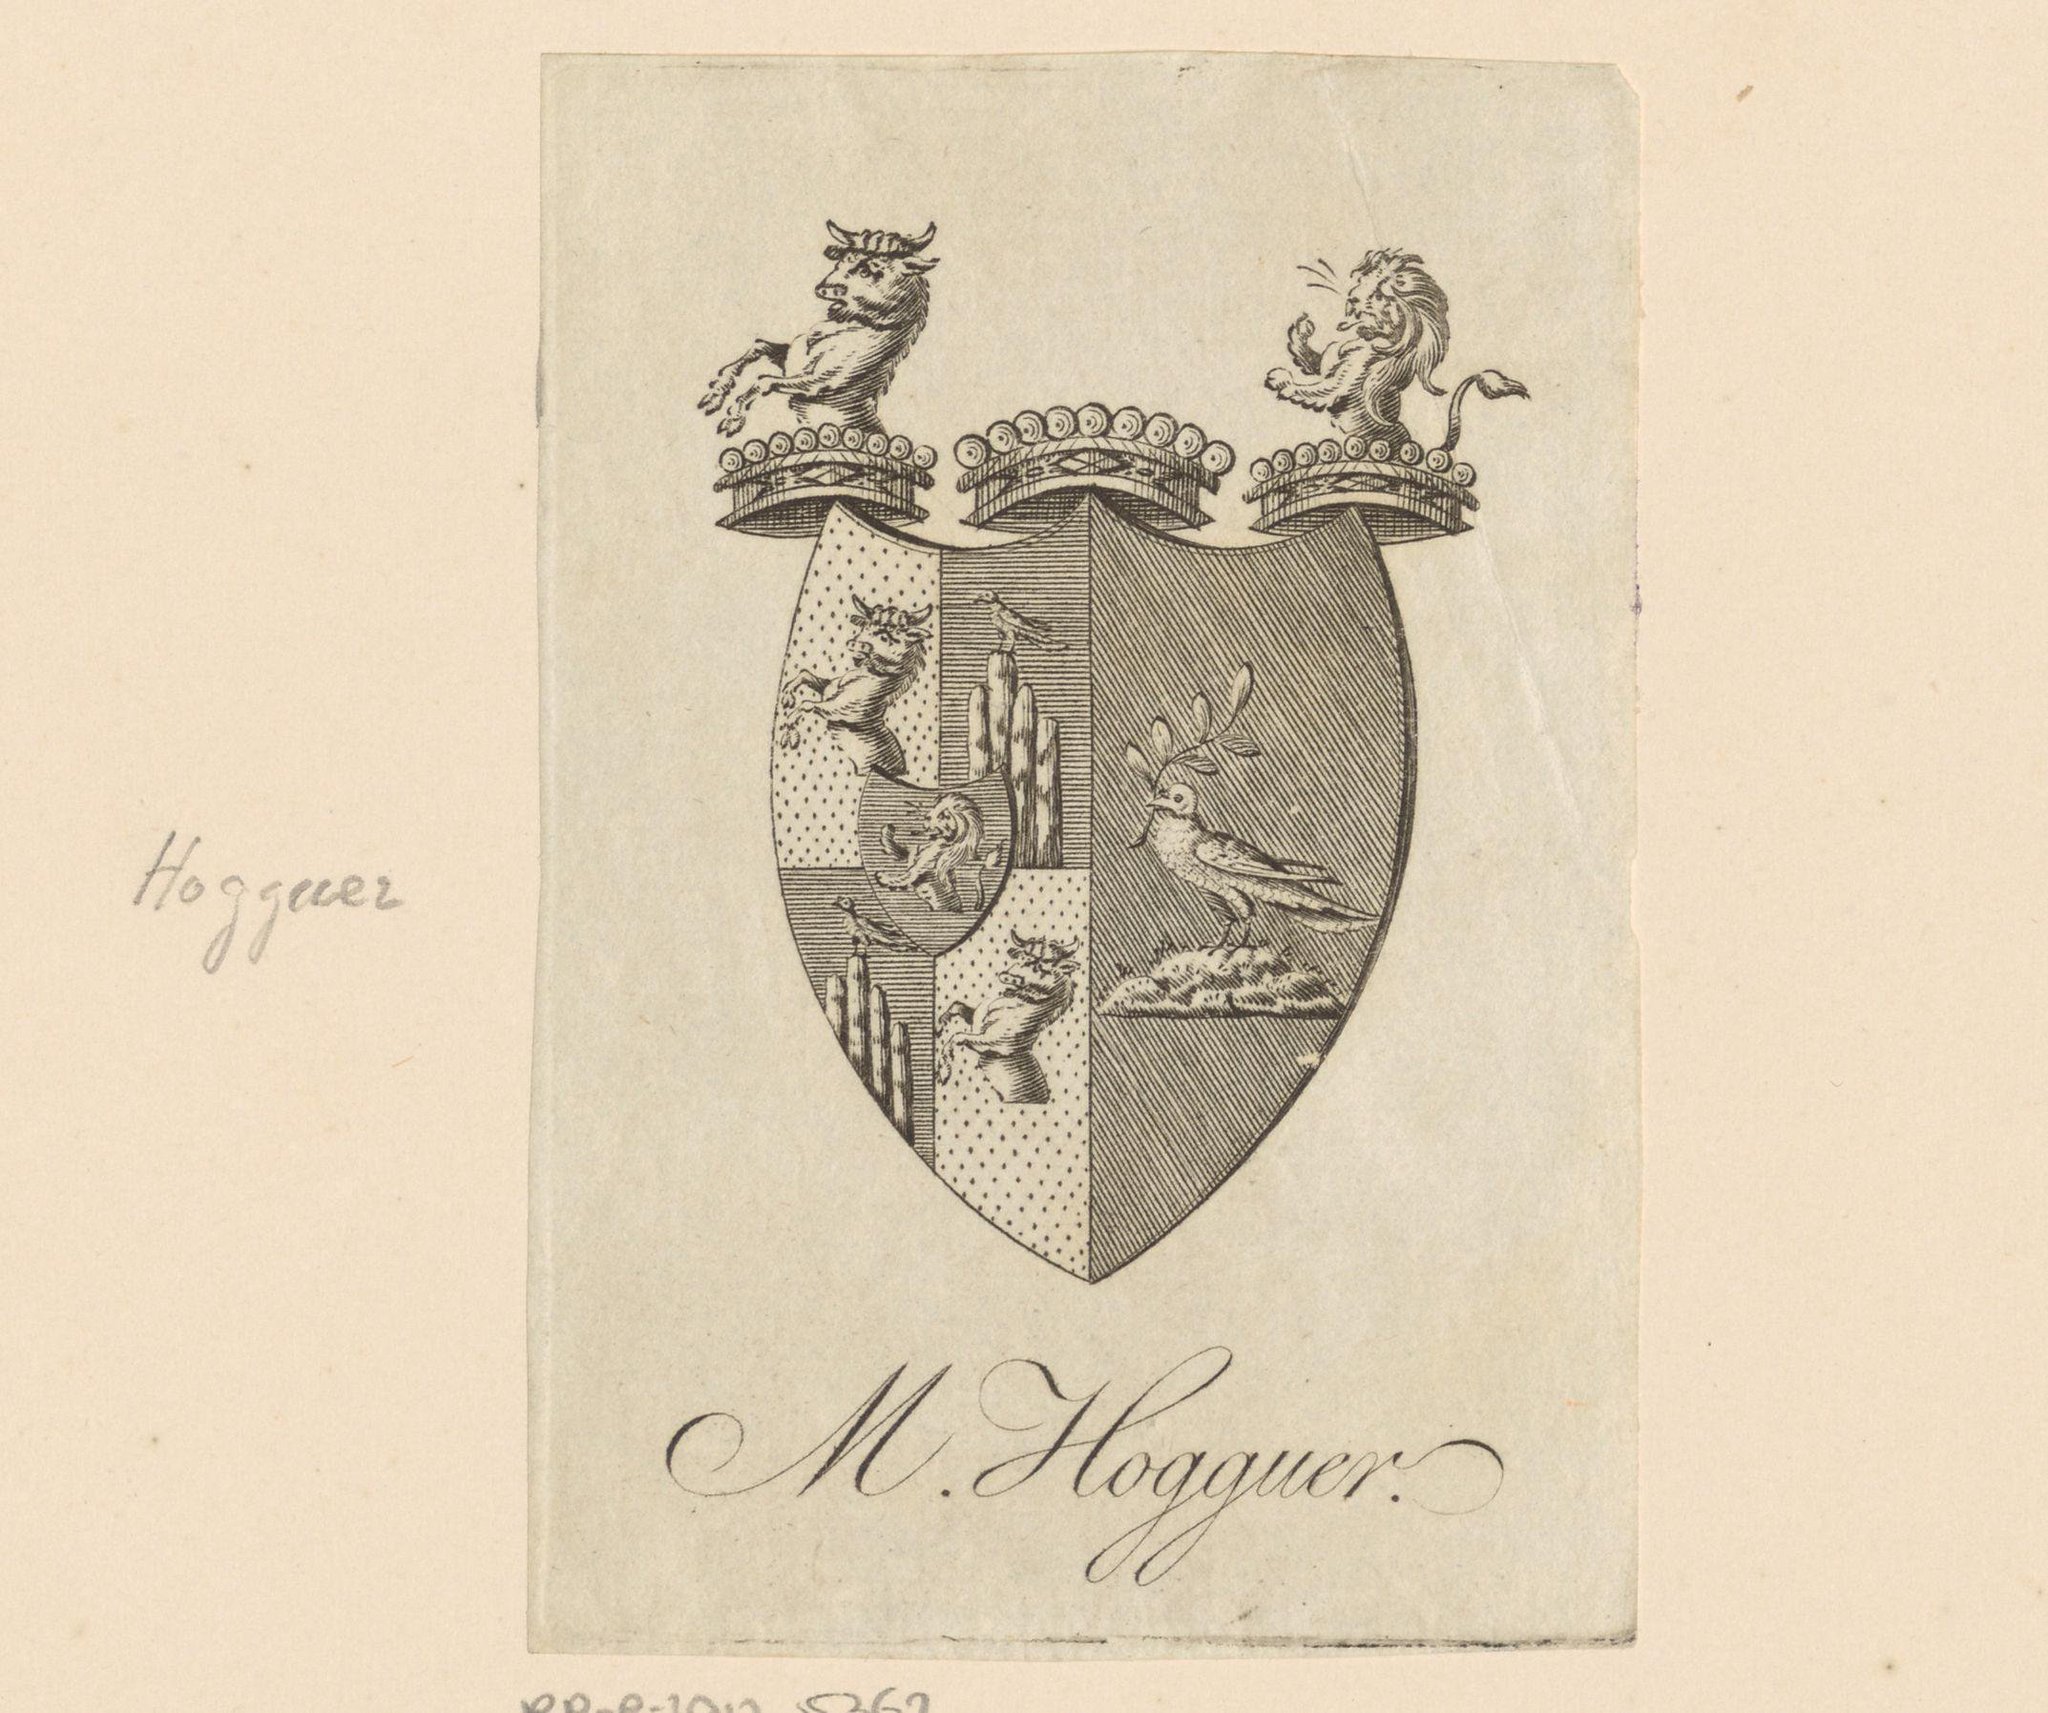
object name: bookplate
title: Ex libris van M. Hogguer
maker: Anonymous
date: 1750-1849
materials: paper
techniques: etching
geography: netherlands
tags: bull, pigeon (as messenger), beasts of prey, predatory animals: lion, armorial bearing, heraldry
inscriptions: inscription: ‘Rietstap, 970.’